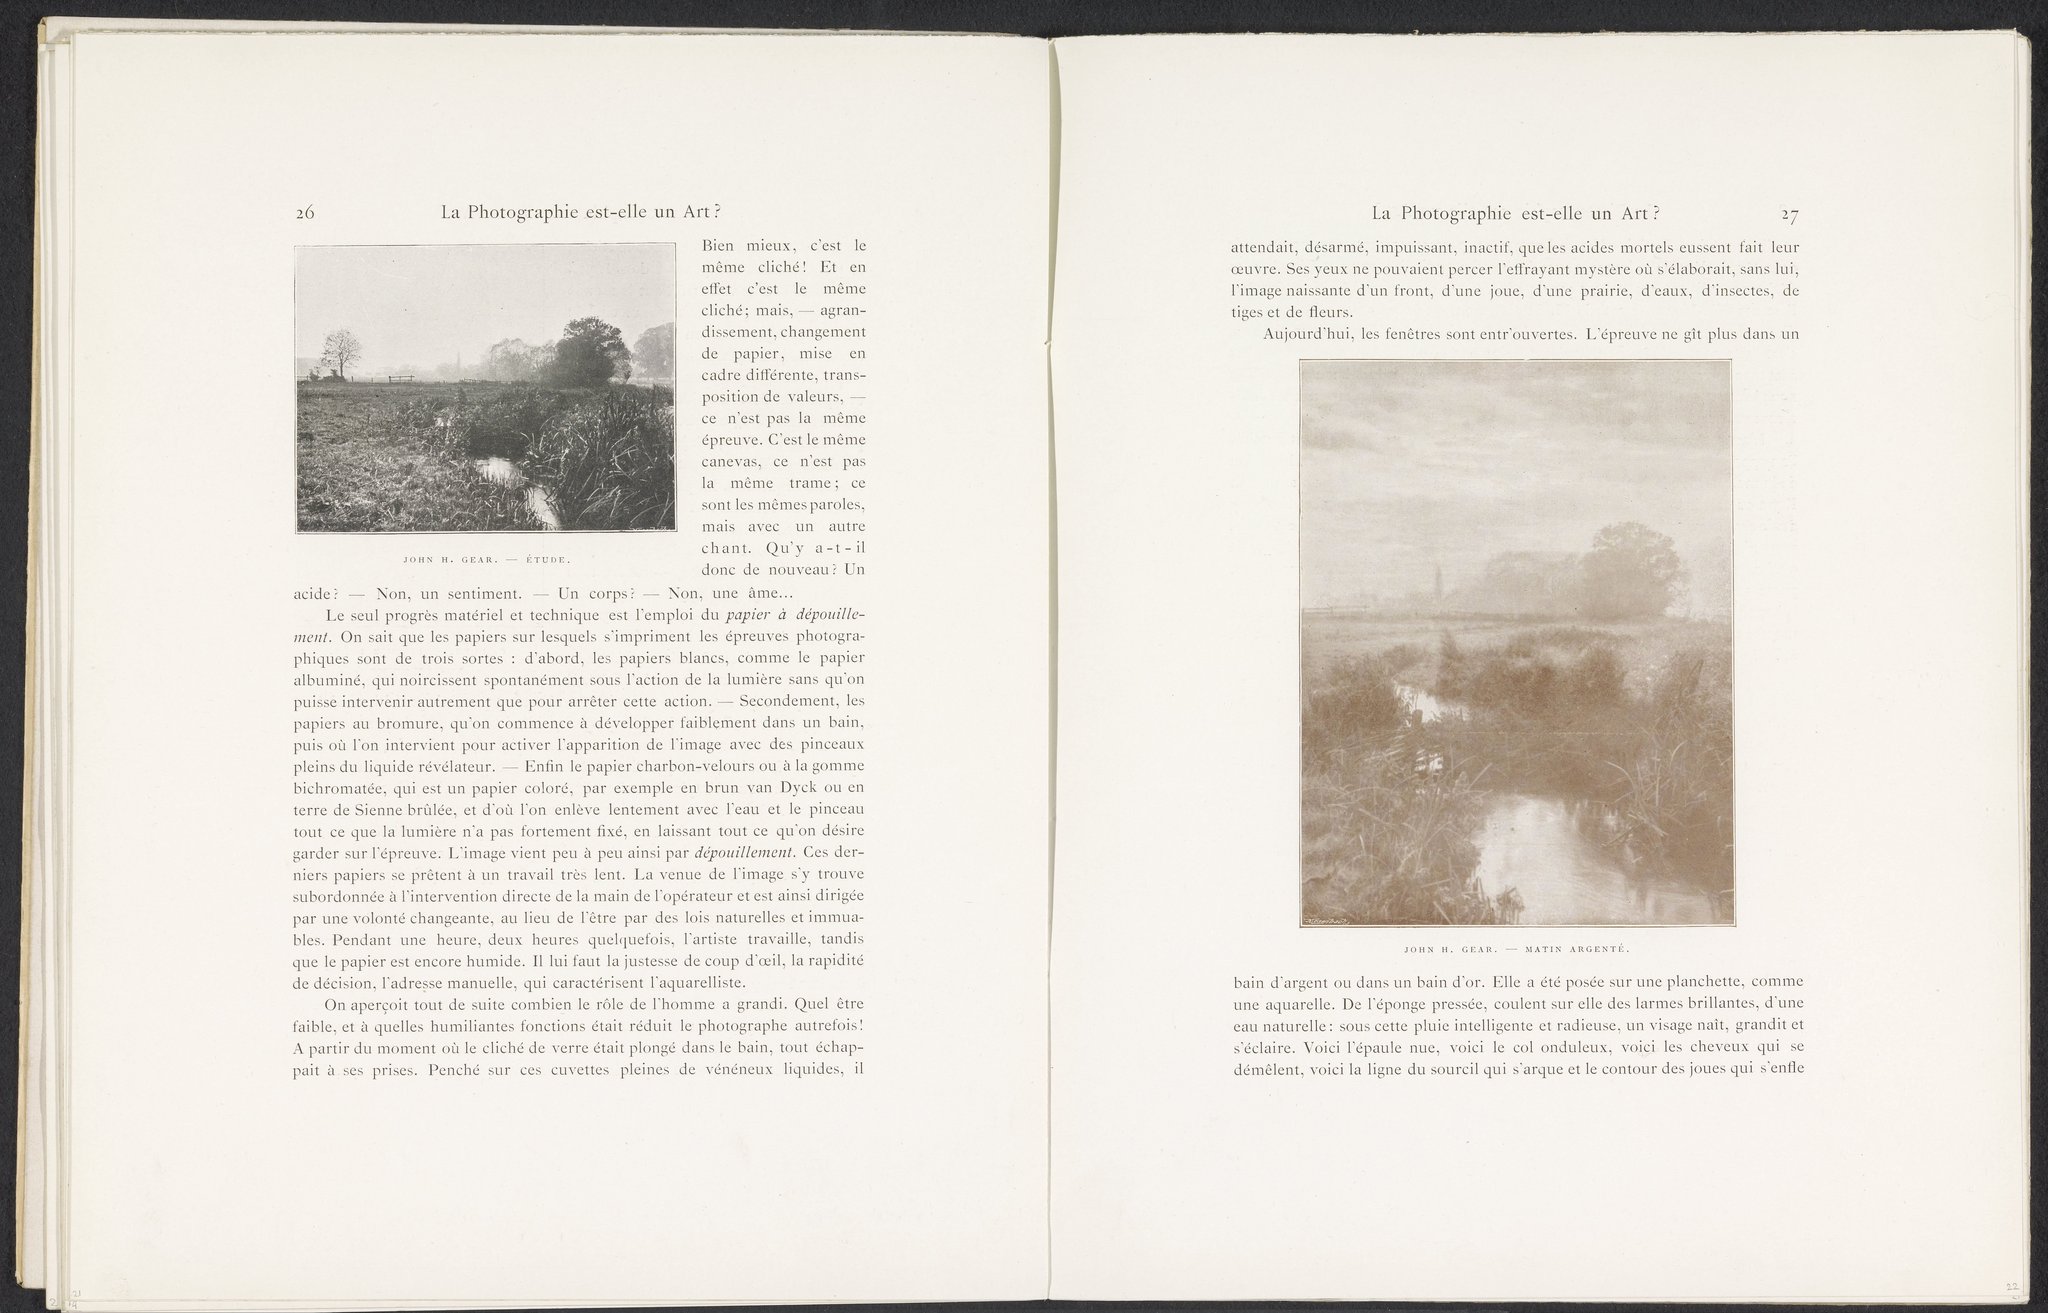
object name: page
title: Matin argenté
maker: john h. gear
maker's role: fotograaf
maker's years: 1864-1946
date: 1889-1899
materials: paper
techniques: autotype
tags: landscapes